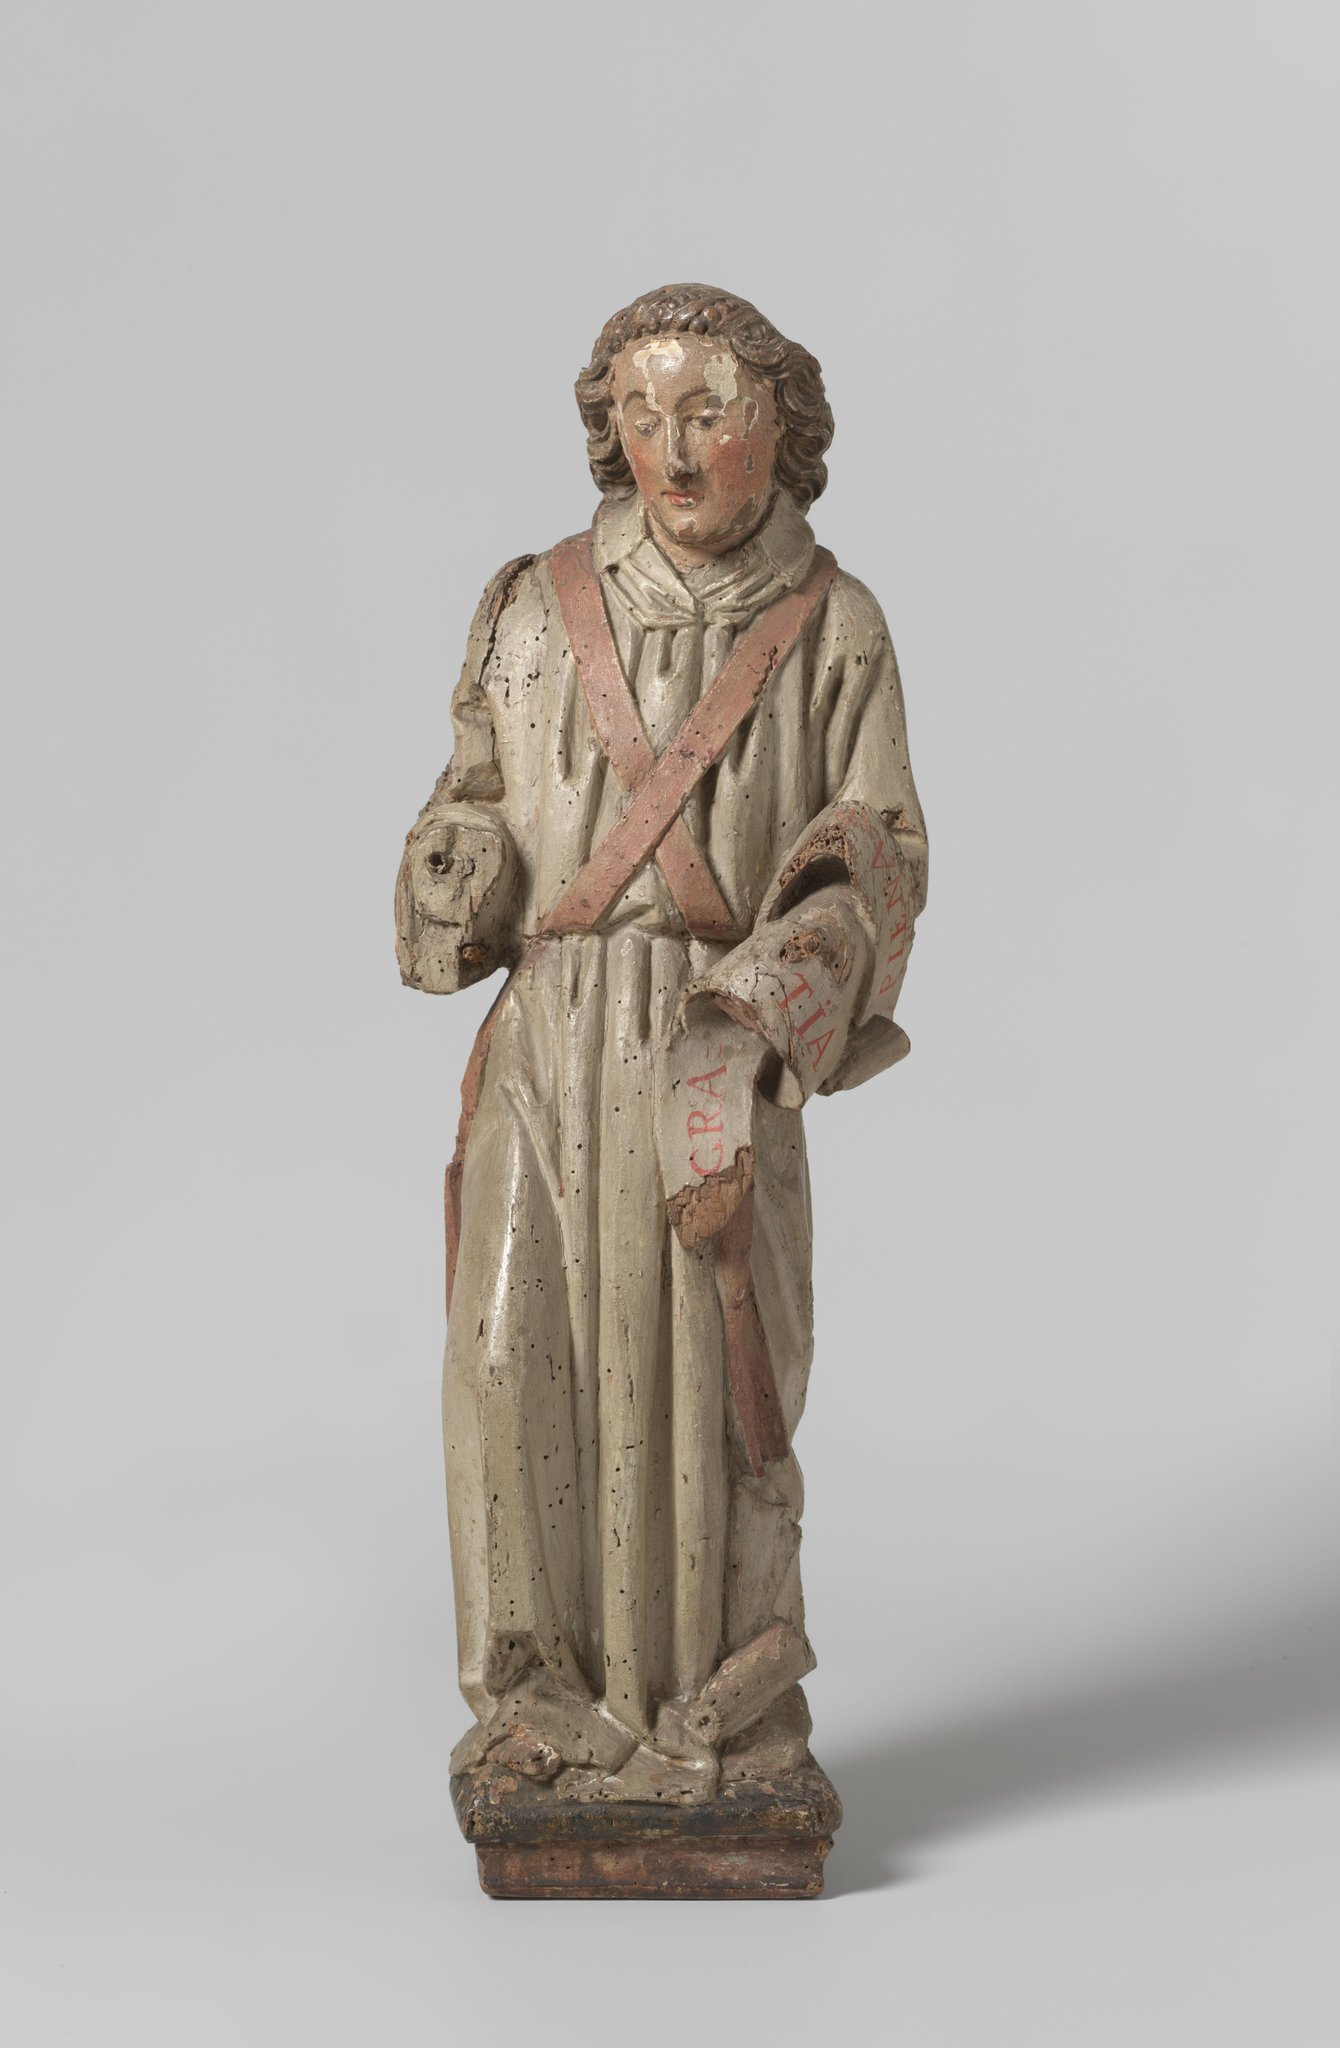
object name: sculpture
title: Archangel Gabriel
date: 1480-1520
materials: wood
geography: north brabant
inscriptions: inscription, on the banderole, in red paint: ‘[AVE] GRATIA PLENA’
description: Hij staat op een geprofileerd, rechthoekig voetstuk met het rechterbeen gebogen en het hoofd iets naar links gewend. In de linkerhand een om de arm gewonden, tot op de bodem afhangende spreukband; de rechterarm is gebogen. Hij draagt albe en amict en een voor de borst gekruiste stool, welke onde de singel doorloopt. Om het hoofd met golvend haar een gewonden parelband. Op de spreukband (latere overschildering): Gra-tia plena.